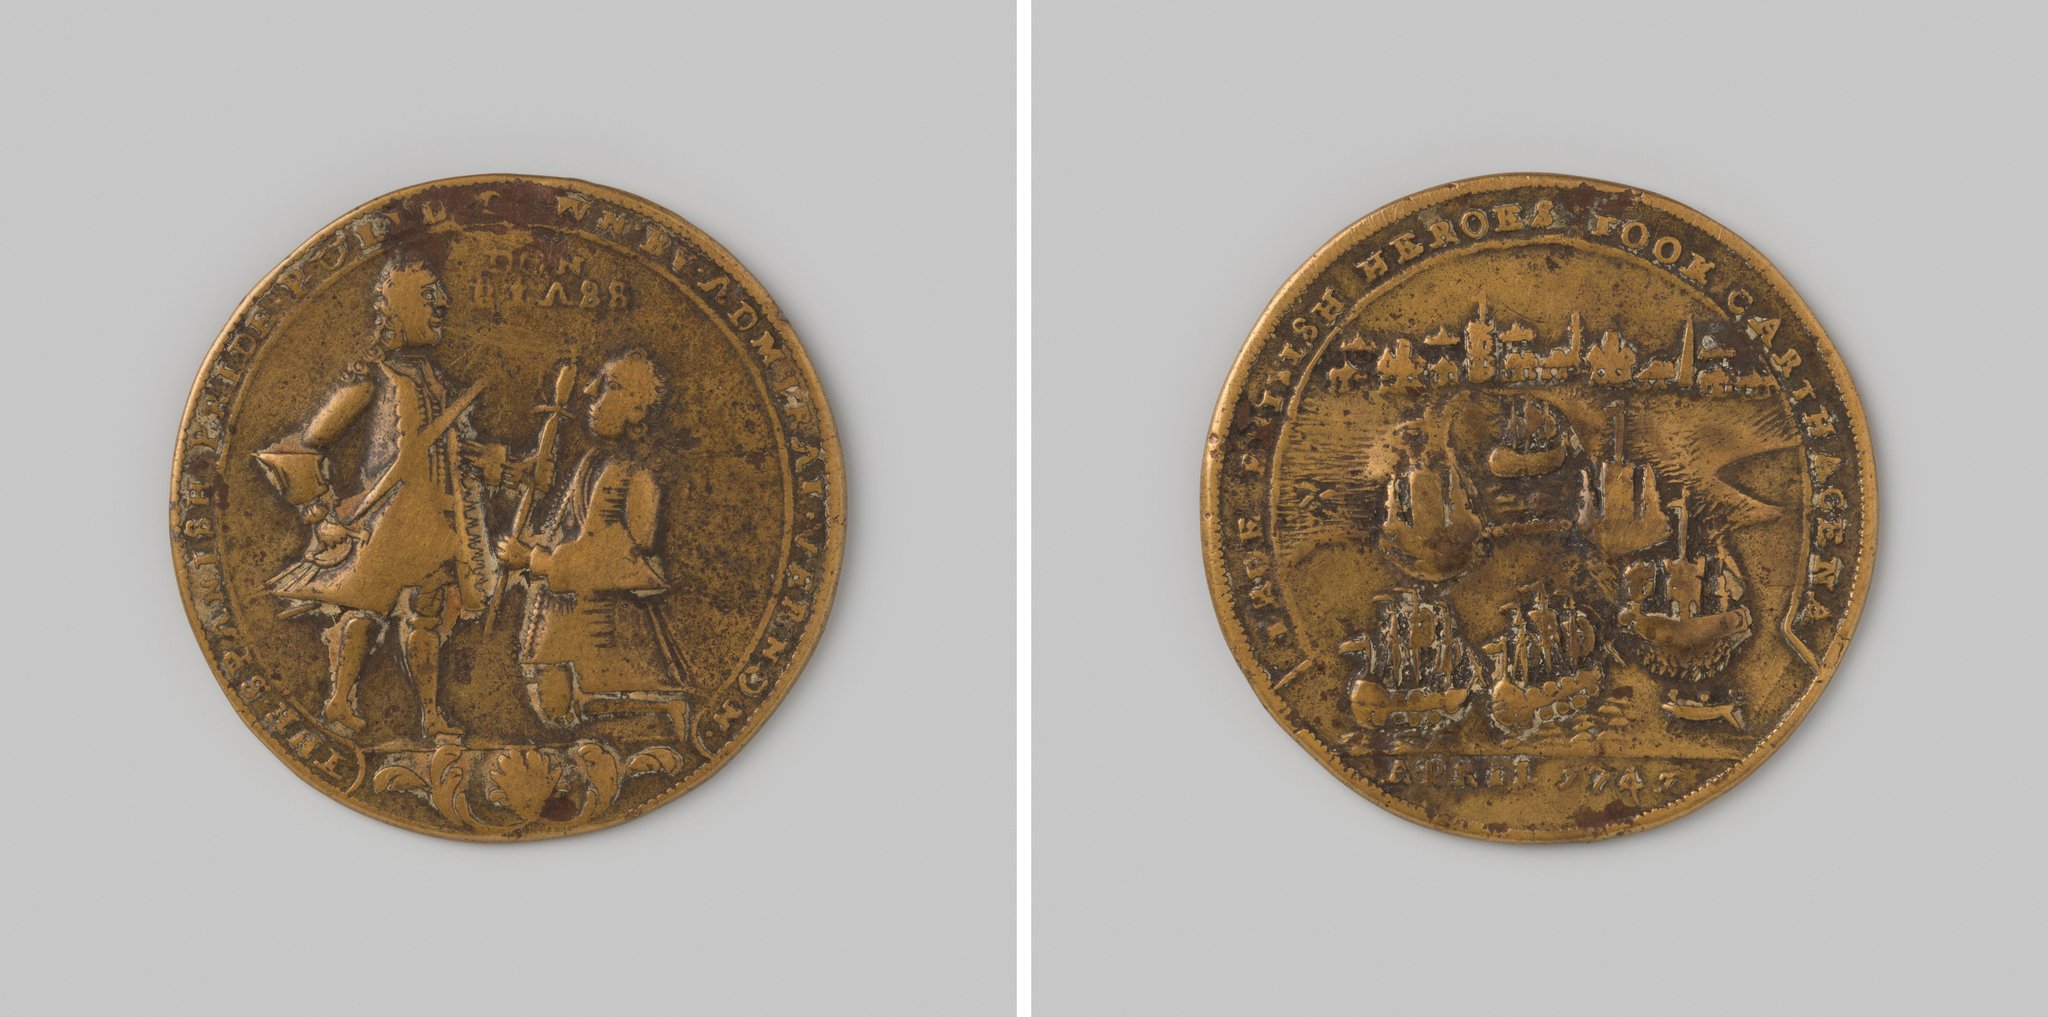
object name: history medal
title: Inname van Carthagena door Admiraal Vernon 1741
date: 1741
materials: brass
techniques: striking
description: Messing penning, op de voorzijde Vernon staand met zwaard, ontvangt het zwaard van de Spaanse verdediger Blas, met omschrift, op de keerzijde de vloot voor de haven van Cartagena met zijn kastelen, met omschrift en afsnedetekst.